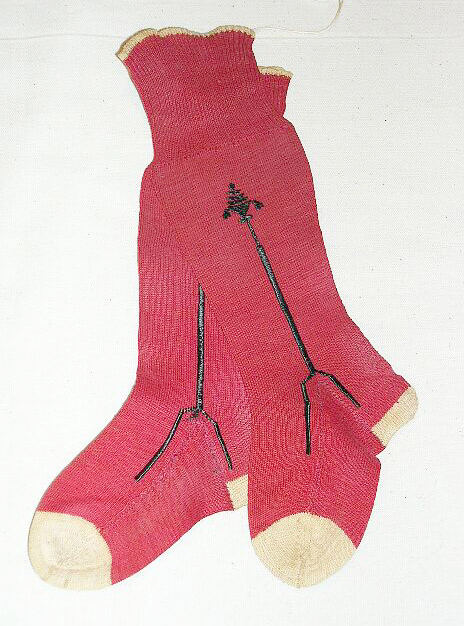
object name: sock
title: Socks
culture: american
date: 1834-1866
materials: cotton, silk